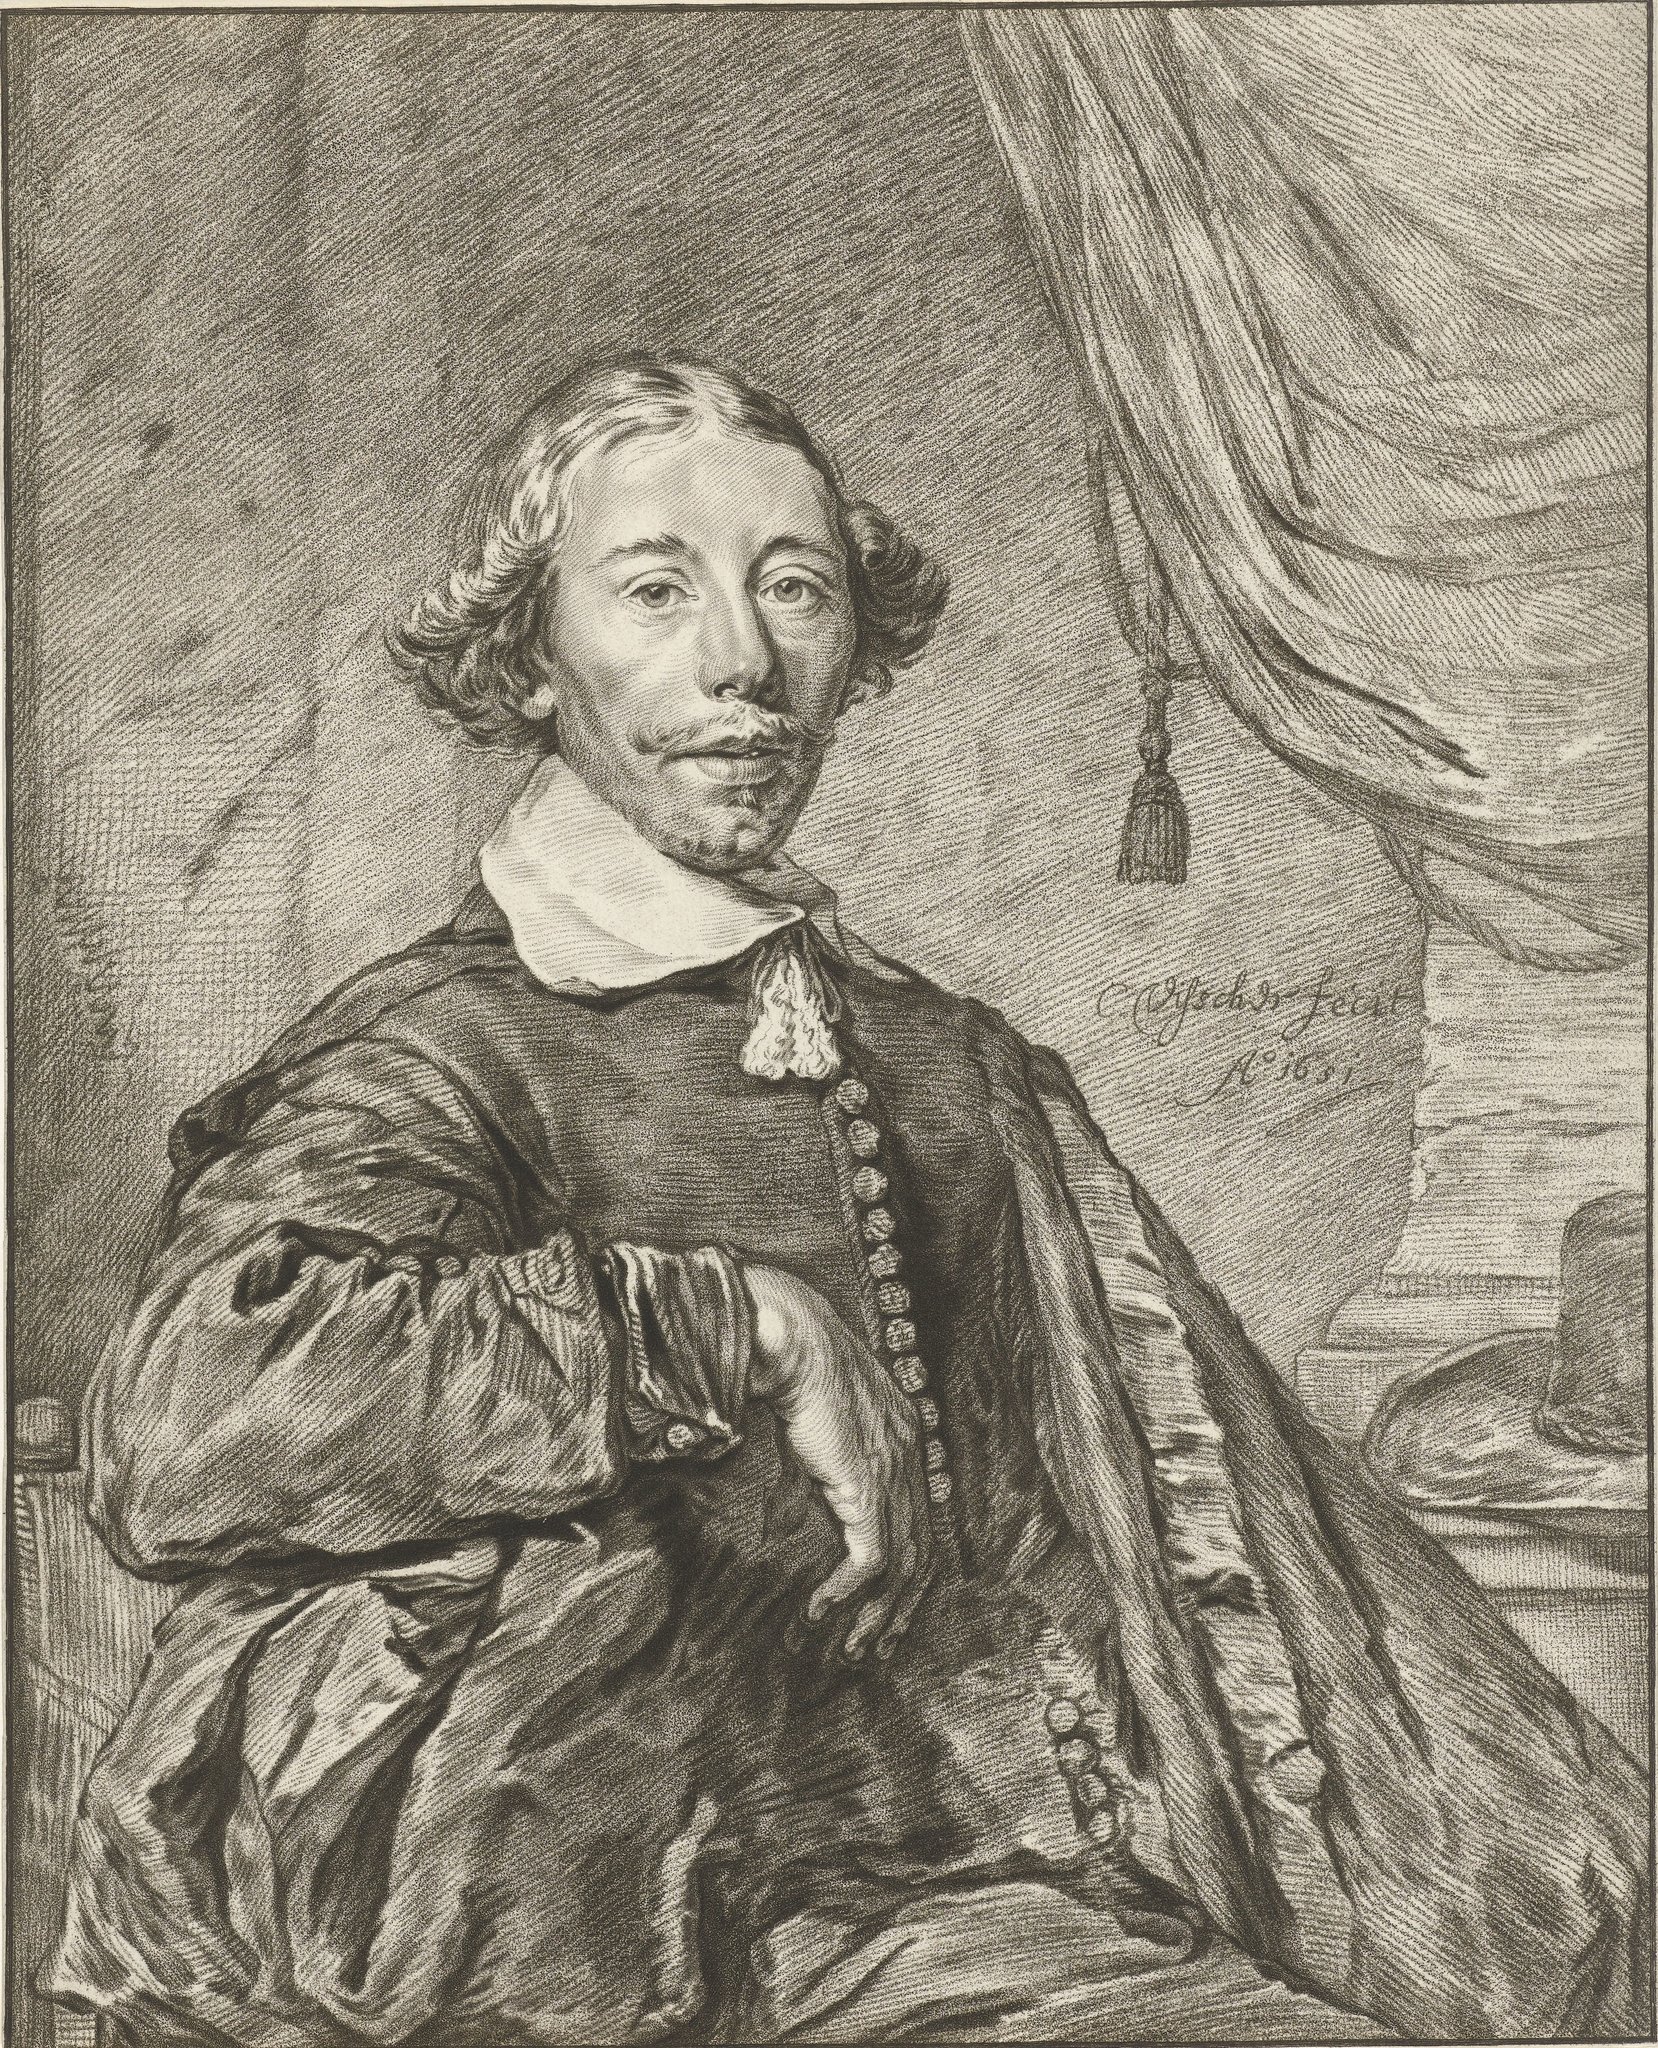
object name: print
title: Portret van een man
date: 1771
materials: paper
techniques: printmaking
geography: amsterdam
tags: adult man, head-gear: hat (+ men's clothes)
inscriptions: collector's mark: Lugt 240, inscription: ‘onafgemaakte proeve. Geoffreerd aan mijne waarde vriend de Weled. Hooh geleerde heer Prof. Allamand te Leyden / C. Visscher. del. Ploos v Amstel JC: Fecit 1771’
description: Portret van een man, zittend voor een gordijn. Zijn hoed ligt op een tafel.